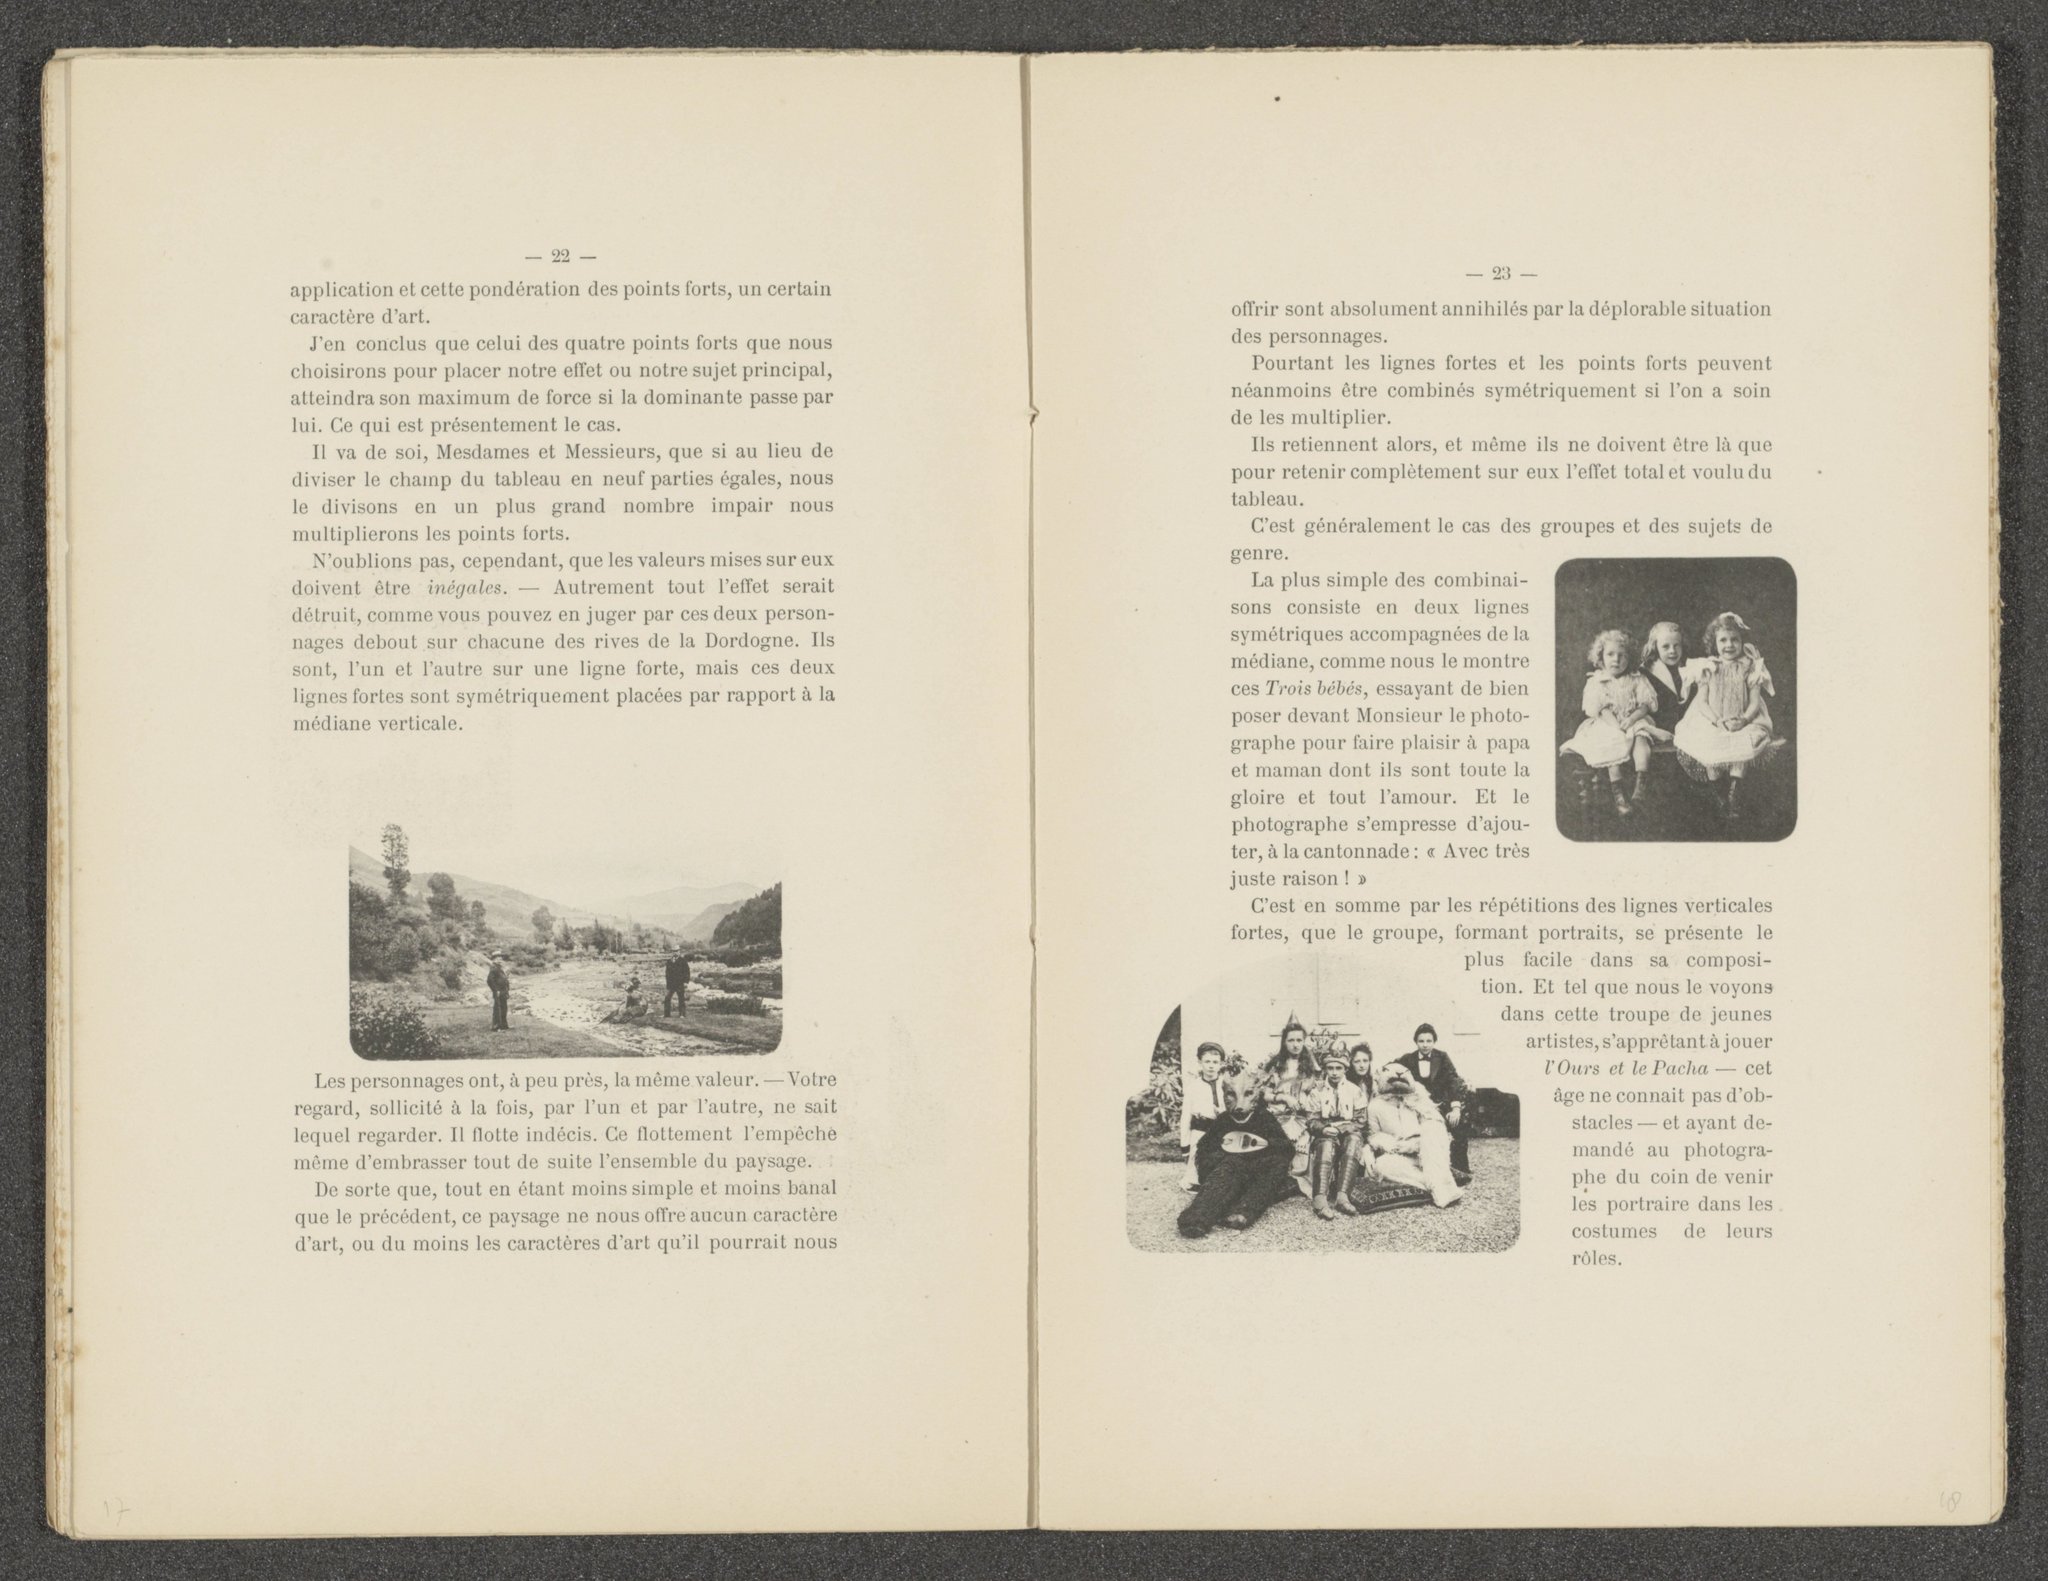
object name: page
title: Twee mannen en twee vrouwen langs een beek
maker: Anonymous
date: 1886-1896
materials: paper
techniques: photograph, printing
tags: adult woman, adult man, brook